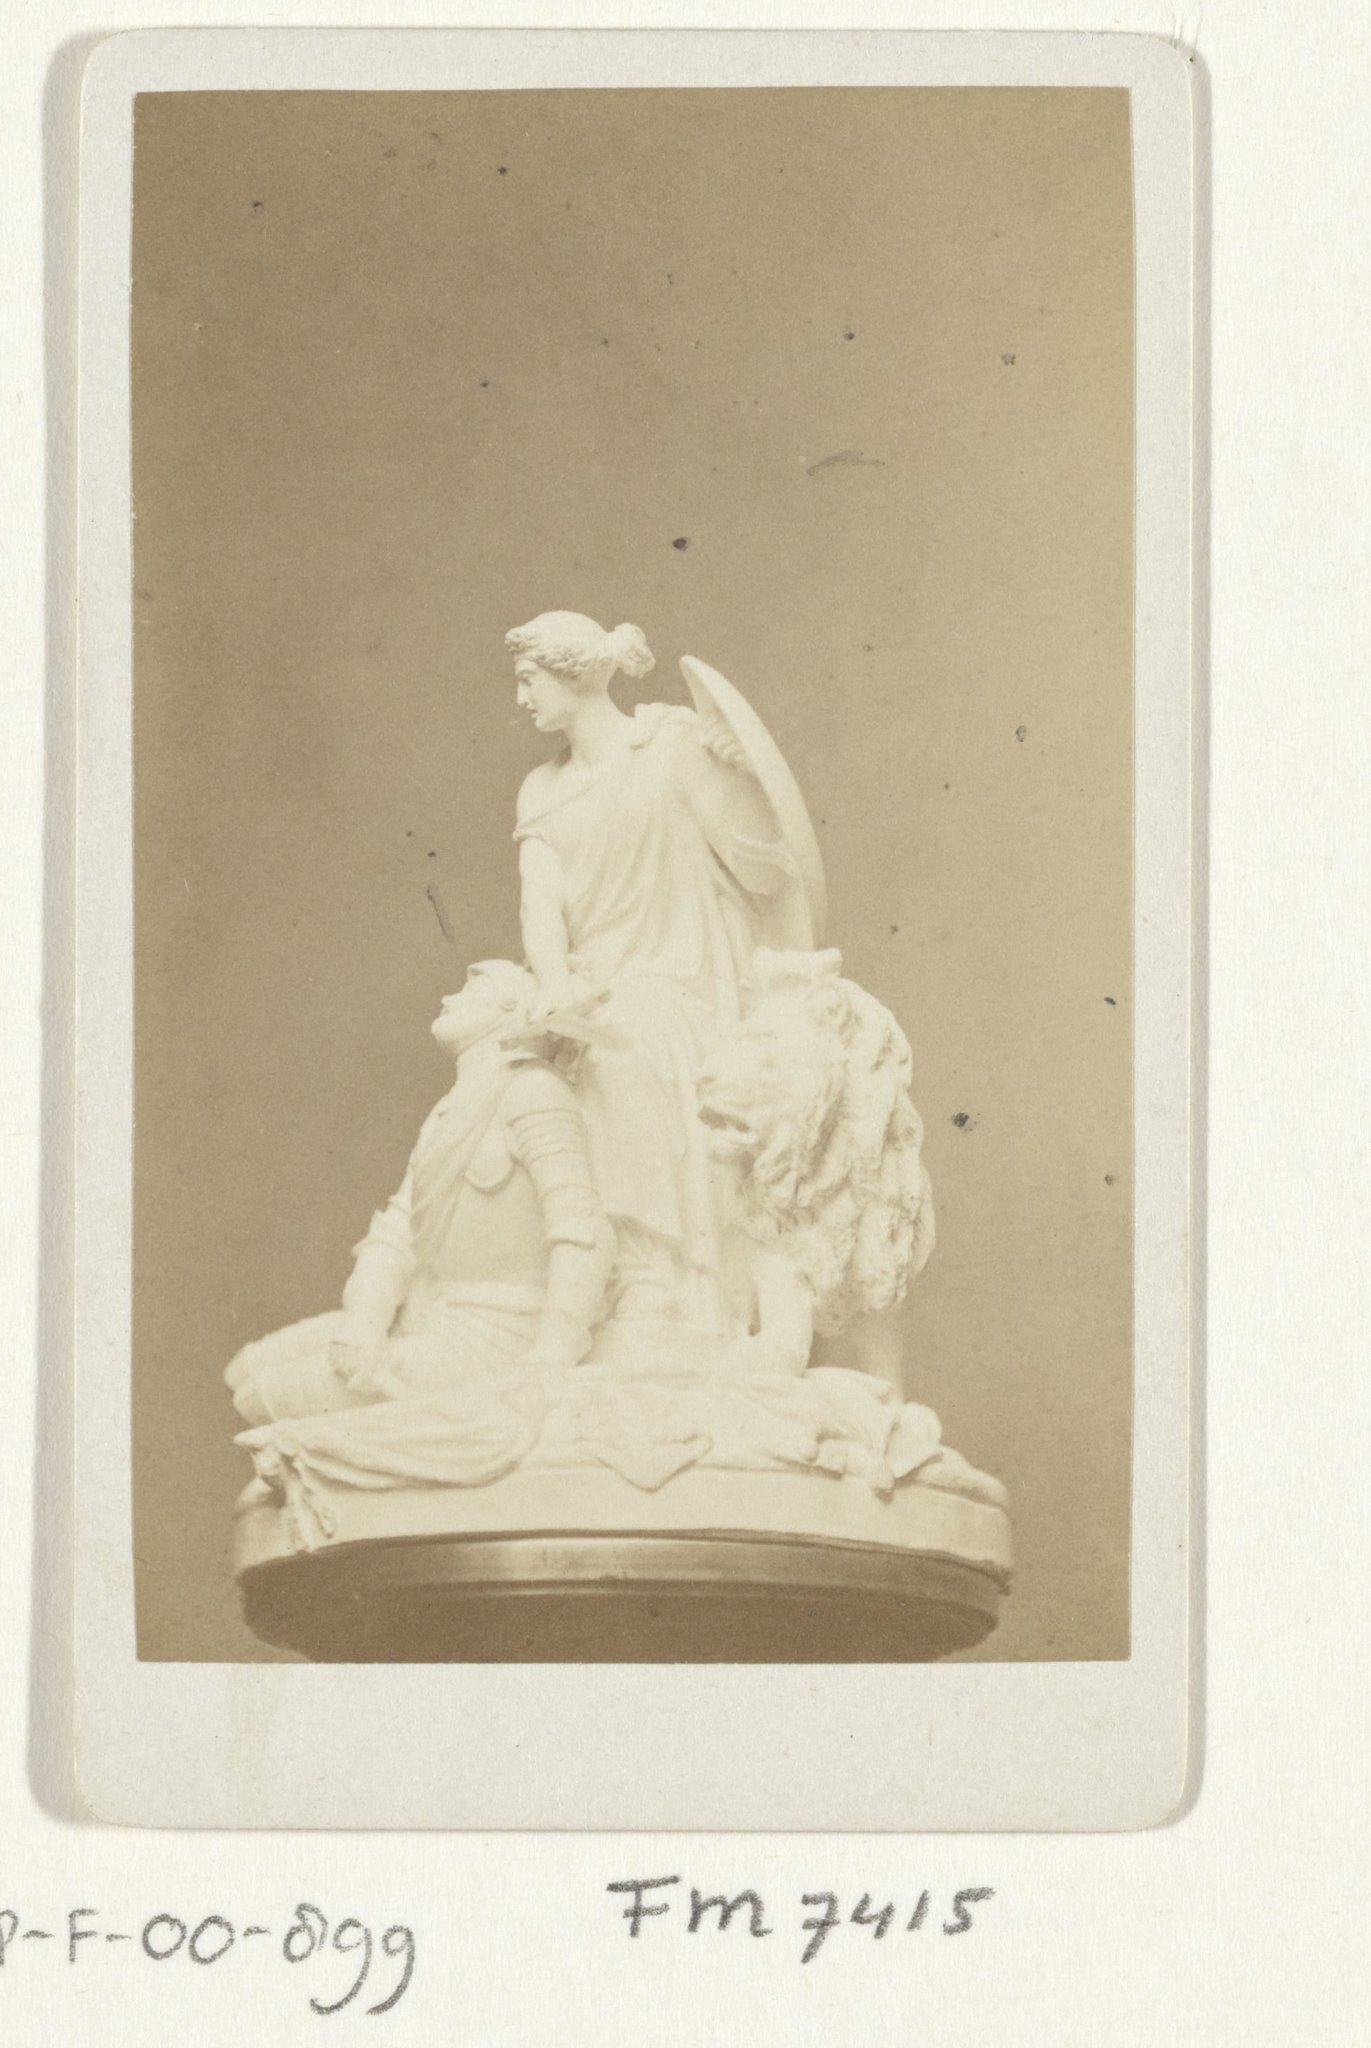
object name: photograph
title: Vier foto's van het ontwerp voor een monument voor de slag bij Heiligerlee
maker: johannes hinderikus egenberger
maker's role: draughtsman, print maker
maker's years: 1822-1897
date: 1868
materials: cardboard, paper, photographic support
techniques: albumen print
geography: groningen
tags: personifications of countries, nations, states, districts, etc., piece of sculpture, reproduction of a piece of sculpture, monument, statue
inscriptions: collector's mark: Lugt 2228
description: Model voor een monument voor de slag bij Heiligerlee (23 mei 1568) onthuld op 23 mei 1868. Het beeld stelt voor: de stervende graaf Adolf van Nassau met de Nederlandse Leeuw en de Nederlandse Maagd. Gipsmodel van vier kanten gefotografeerd.